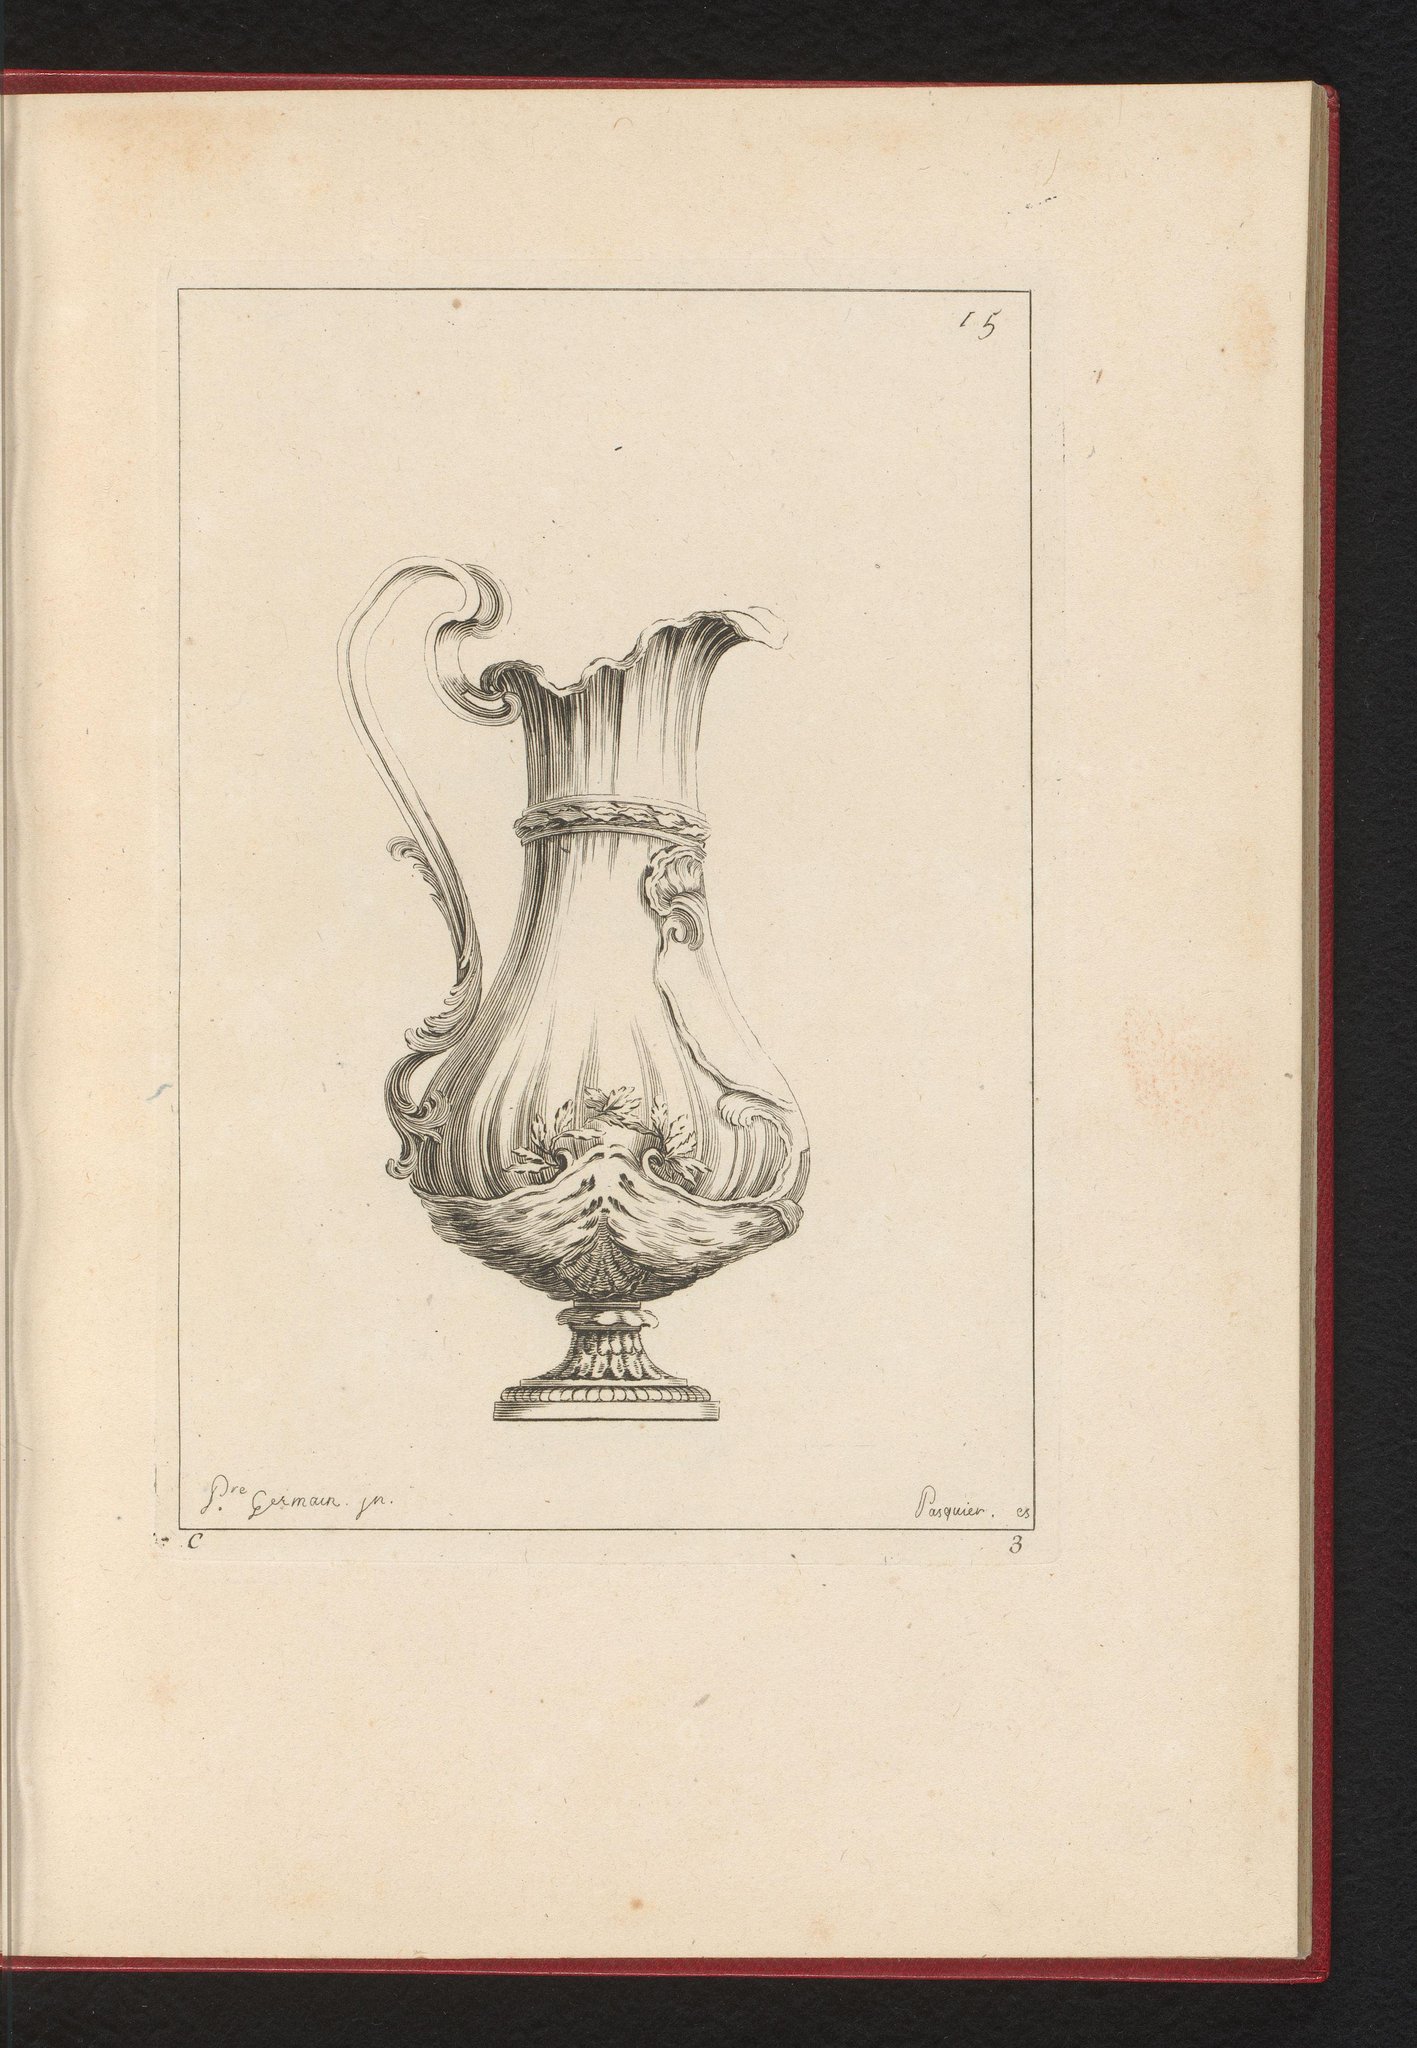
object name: print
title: Elements d'orfevrerie divisés en deux parties de cinquante feuilles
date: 1748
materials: paper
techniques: etching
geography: paris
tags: jeweller, goldsmith, silversmith, container of ceramics: jar, jug, pot, vase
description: Een aantal van de objecten in deze reeks heeft een eigen ondertitel, die verwijst naar genummerde 'cahiers' (afleveringen) waarin de prenten werden uitgegeven. Het is onduidelijk welke objecten recies bij welke aflevering horen. Daarom is die ondertitel enkel verwerkt bij de prent waarop die voorkomt.